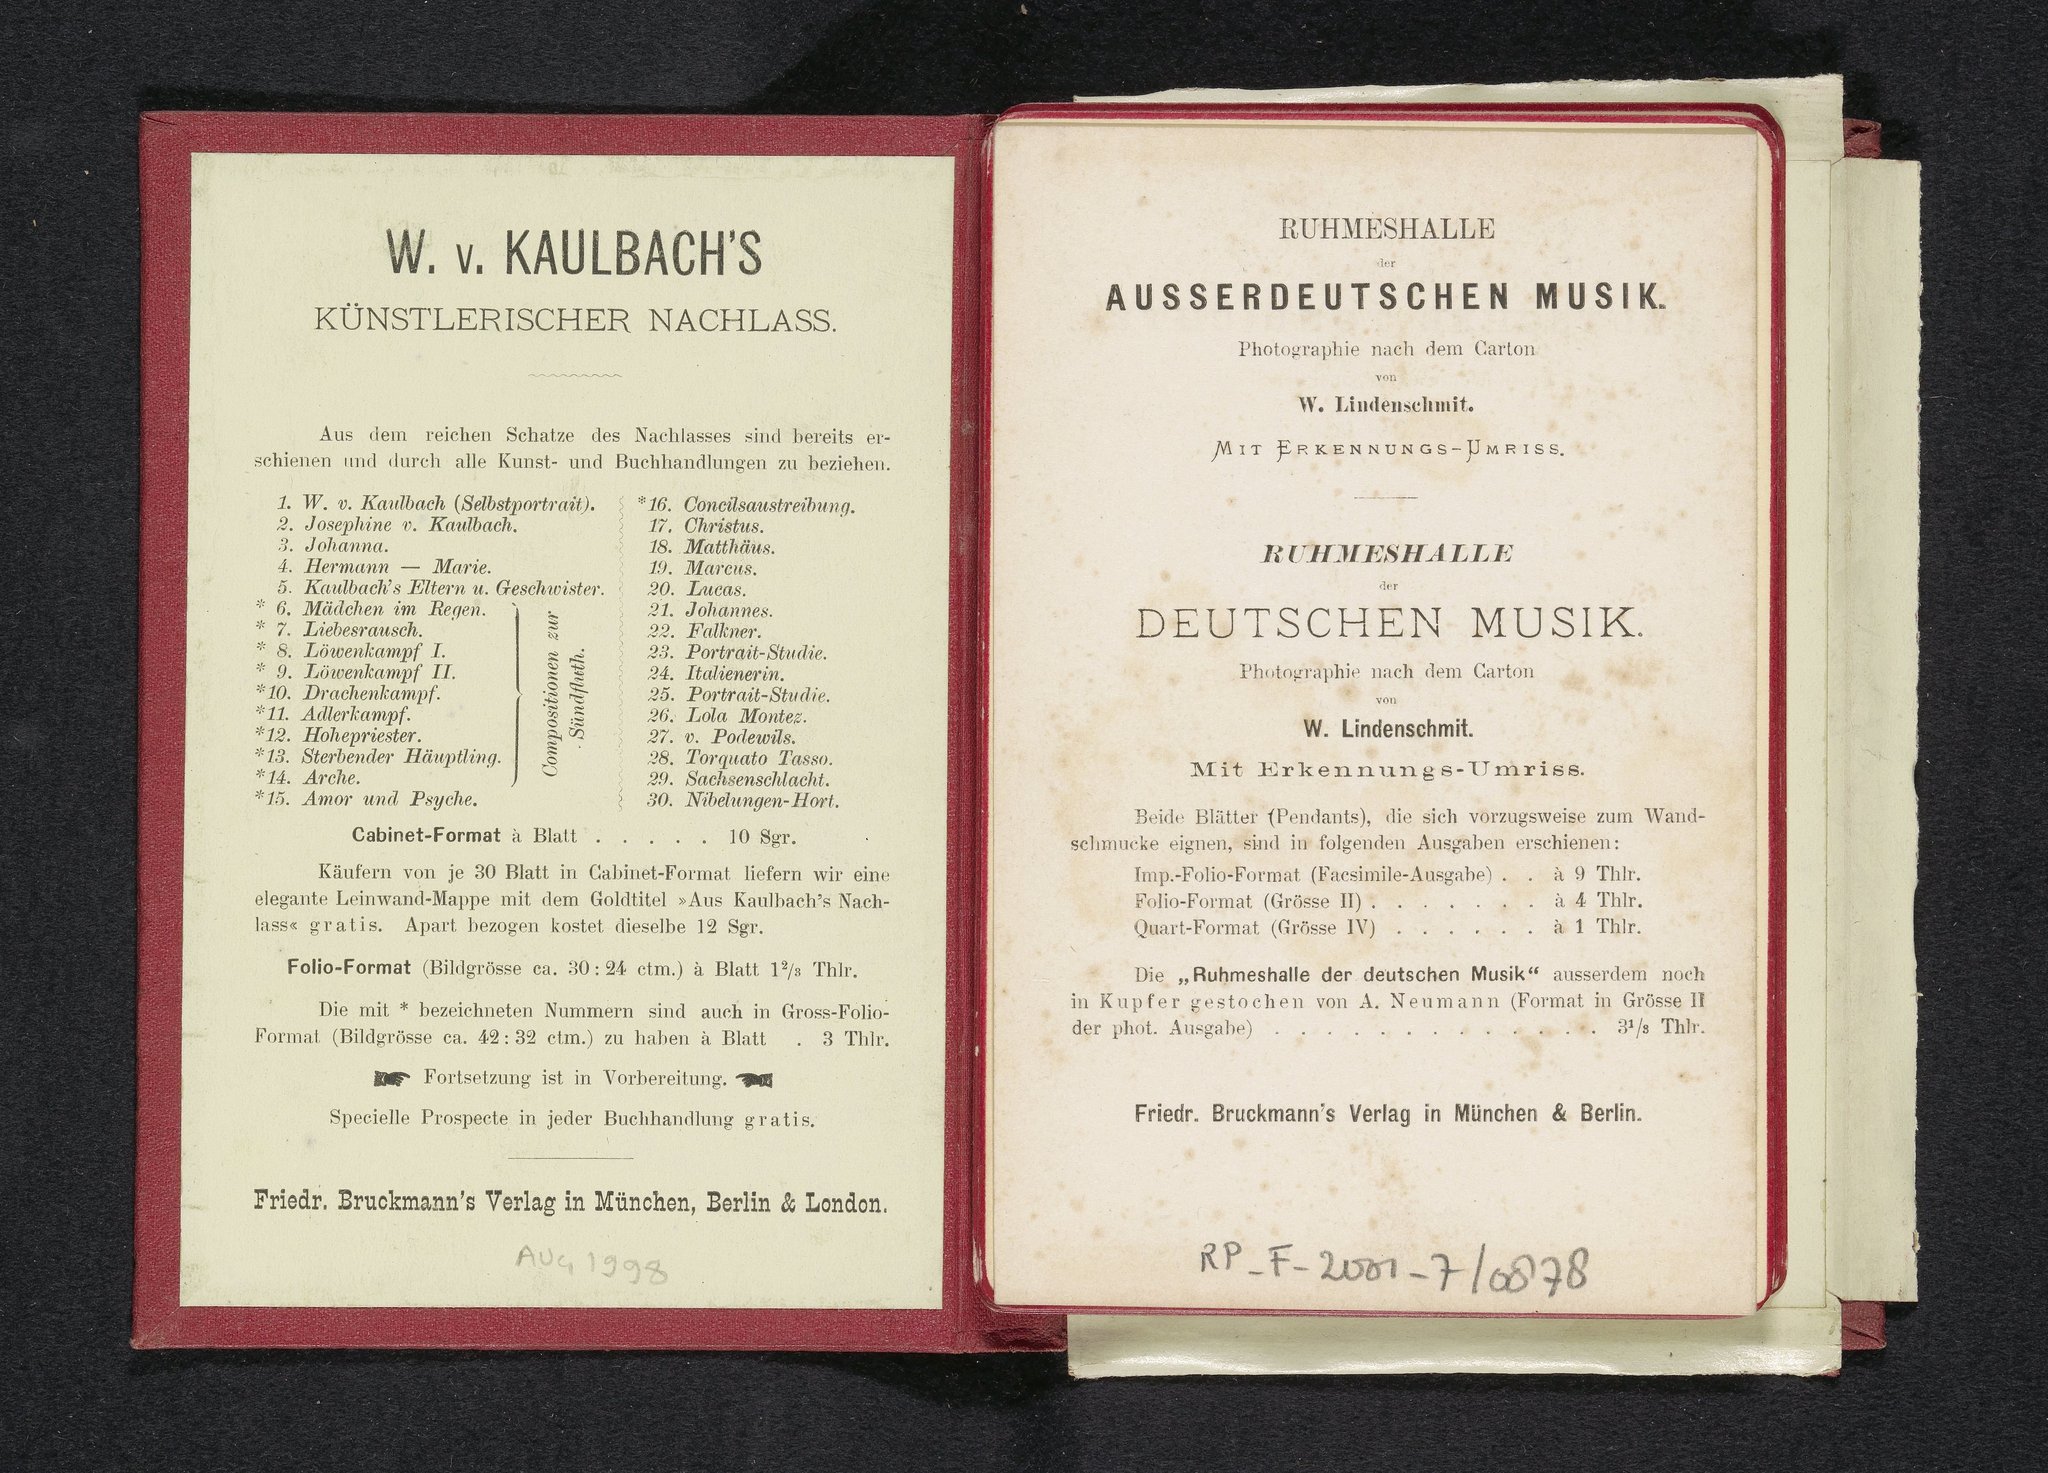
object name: book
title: Gallerie französischer und italienischer Tondichter : Brustbilder nach Original-Gemälden von Eugen Felix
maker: w. lindenschmit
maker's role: fotograaf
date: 1878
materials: cardboard, linen, paper, photographic support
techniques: albumen print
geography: munich